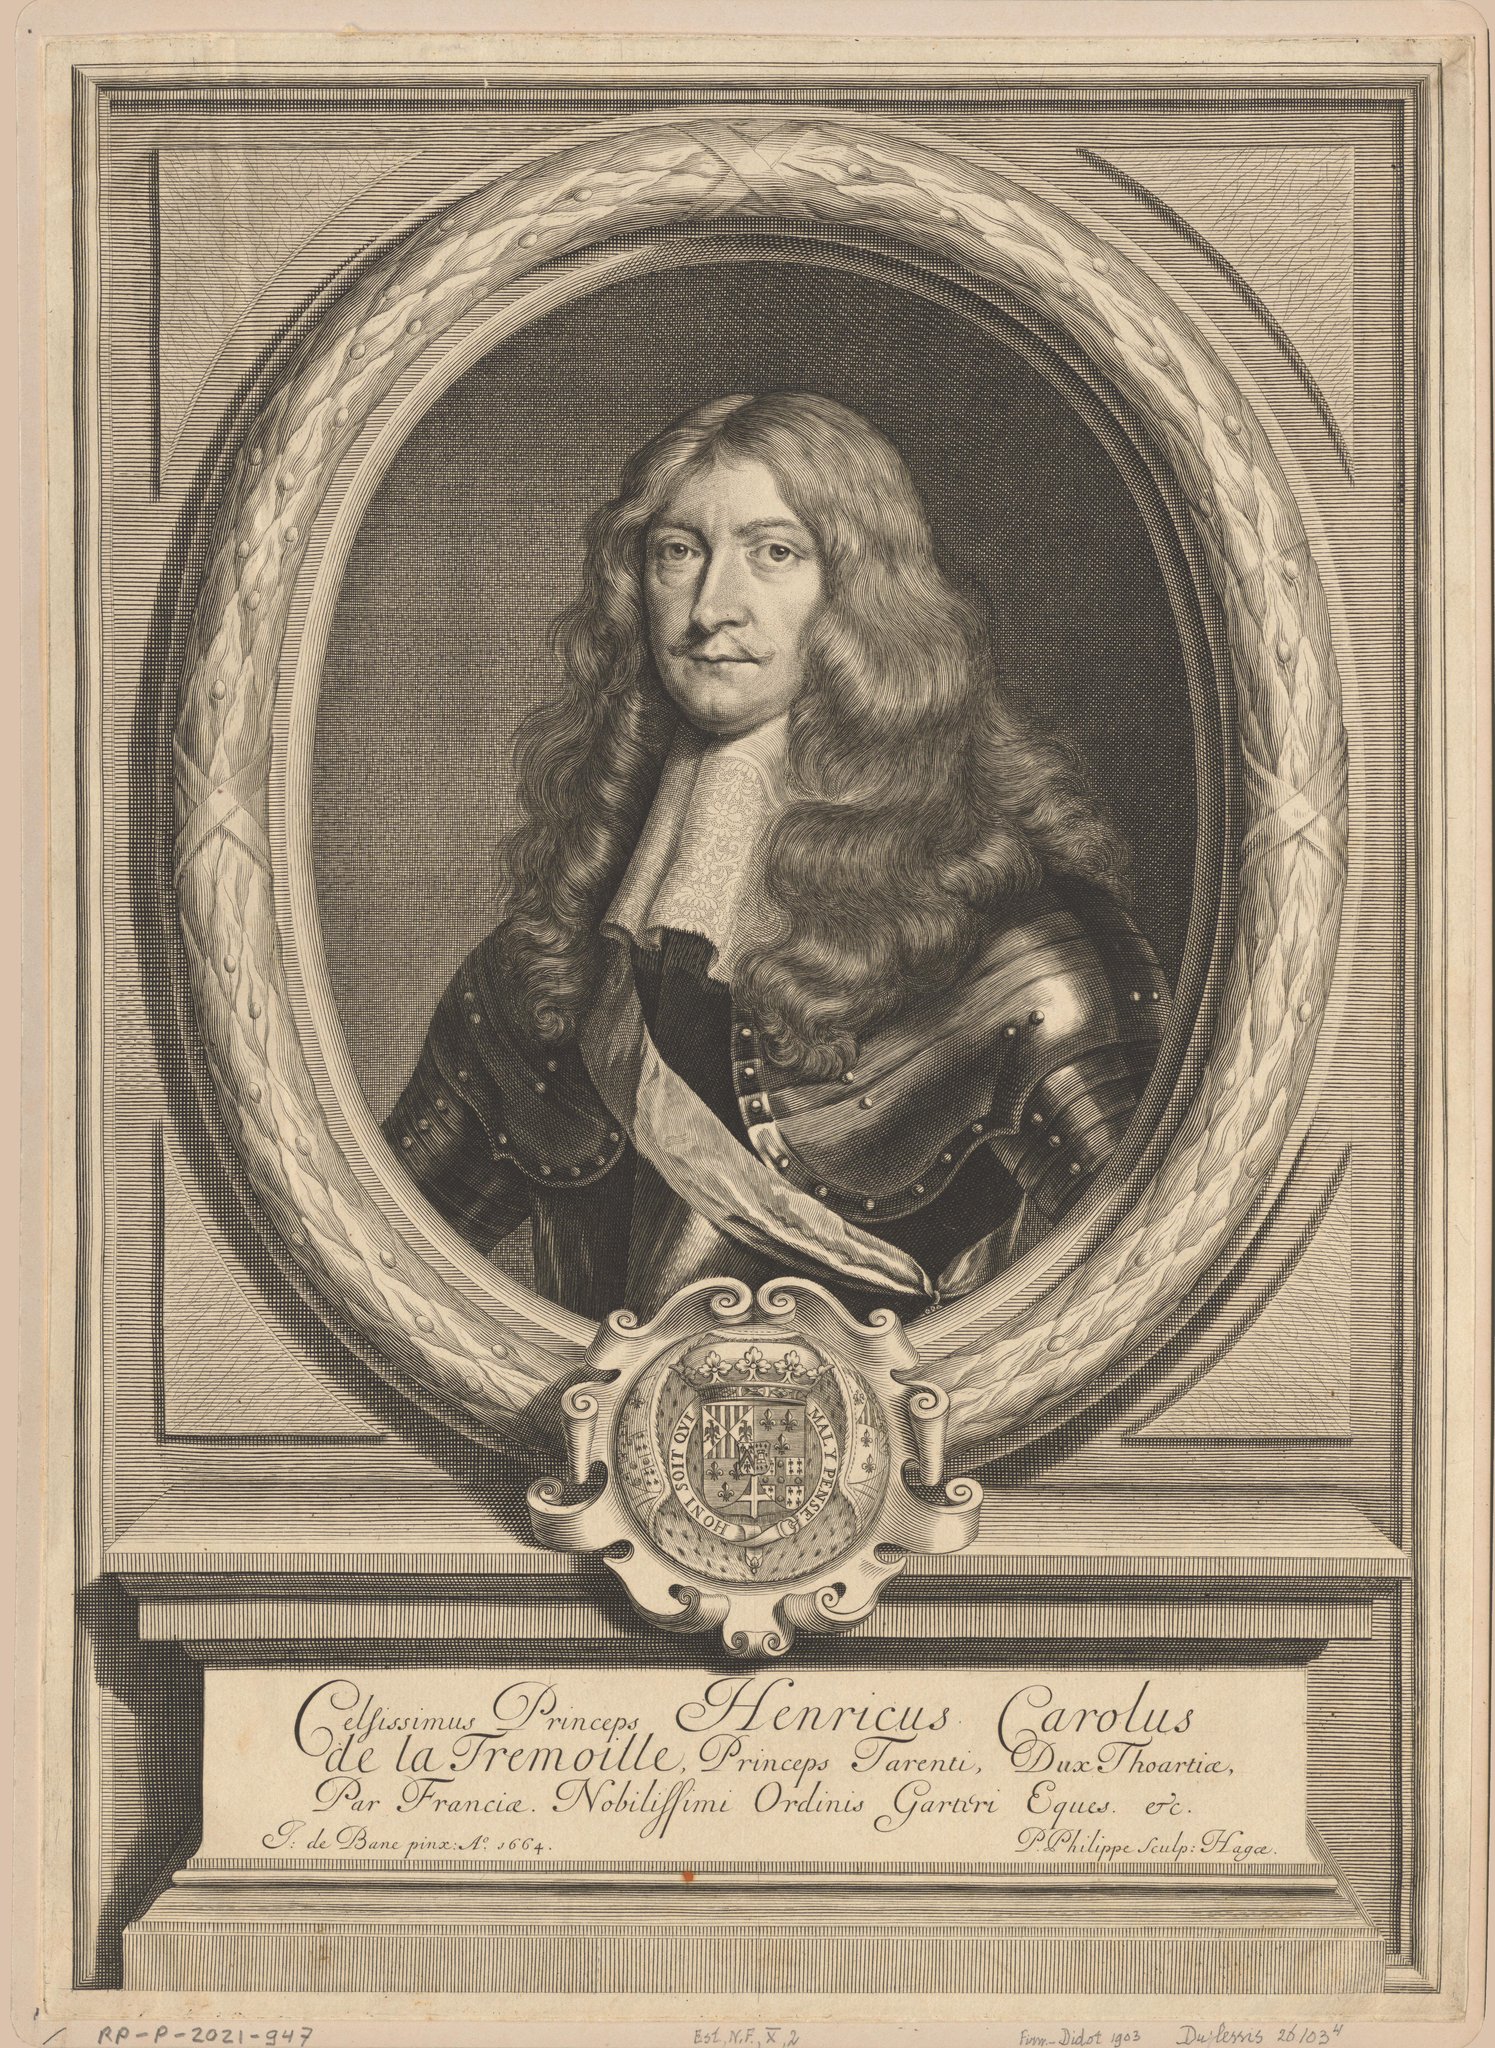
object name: print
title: Portret van Henri Charles de La Trémoille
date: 1664-1666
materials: paper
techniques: engraving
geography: the hague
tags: ornament ~ medallion, armour, historical persons, armorial bearing, heraldry